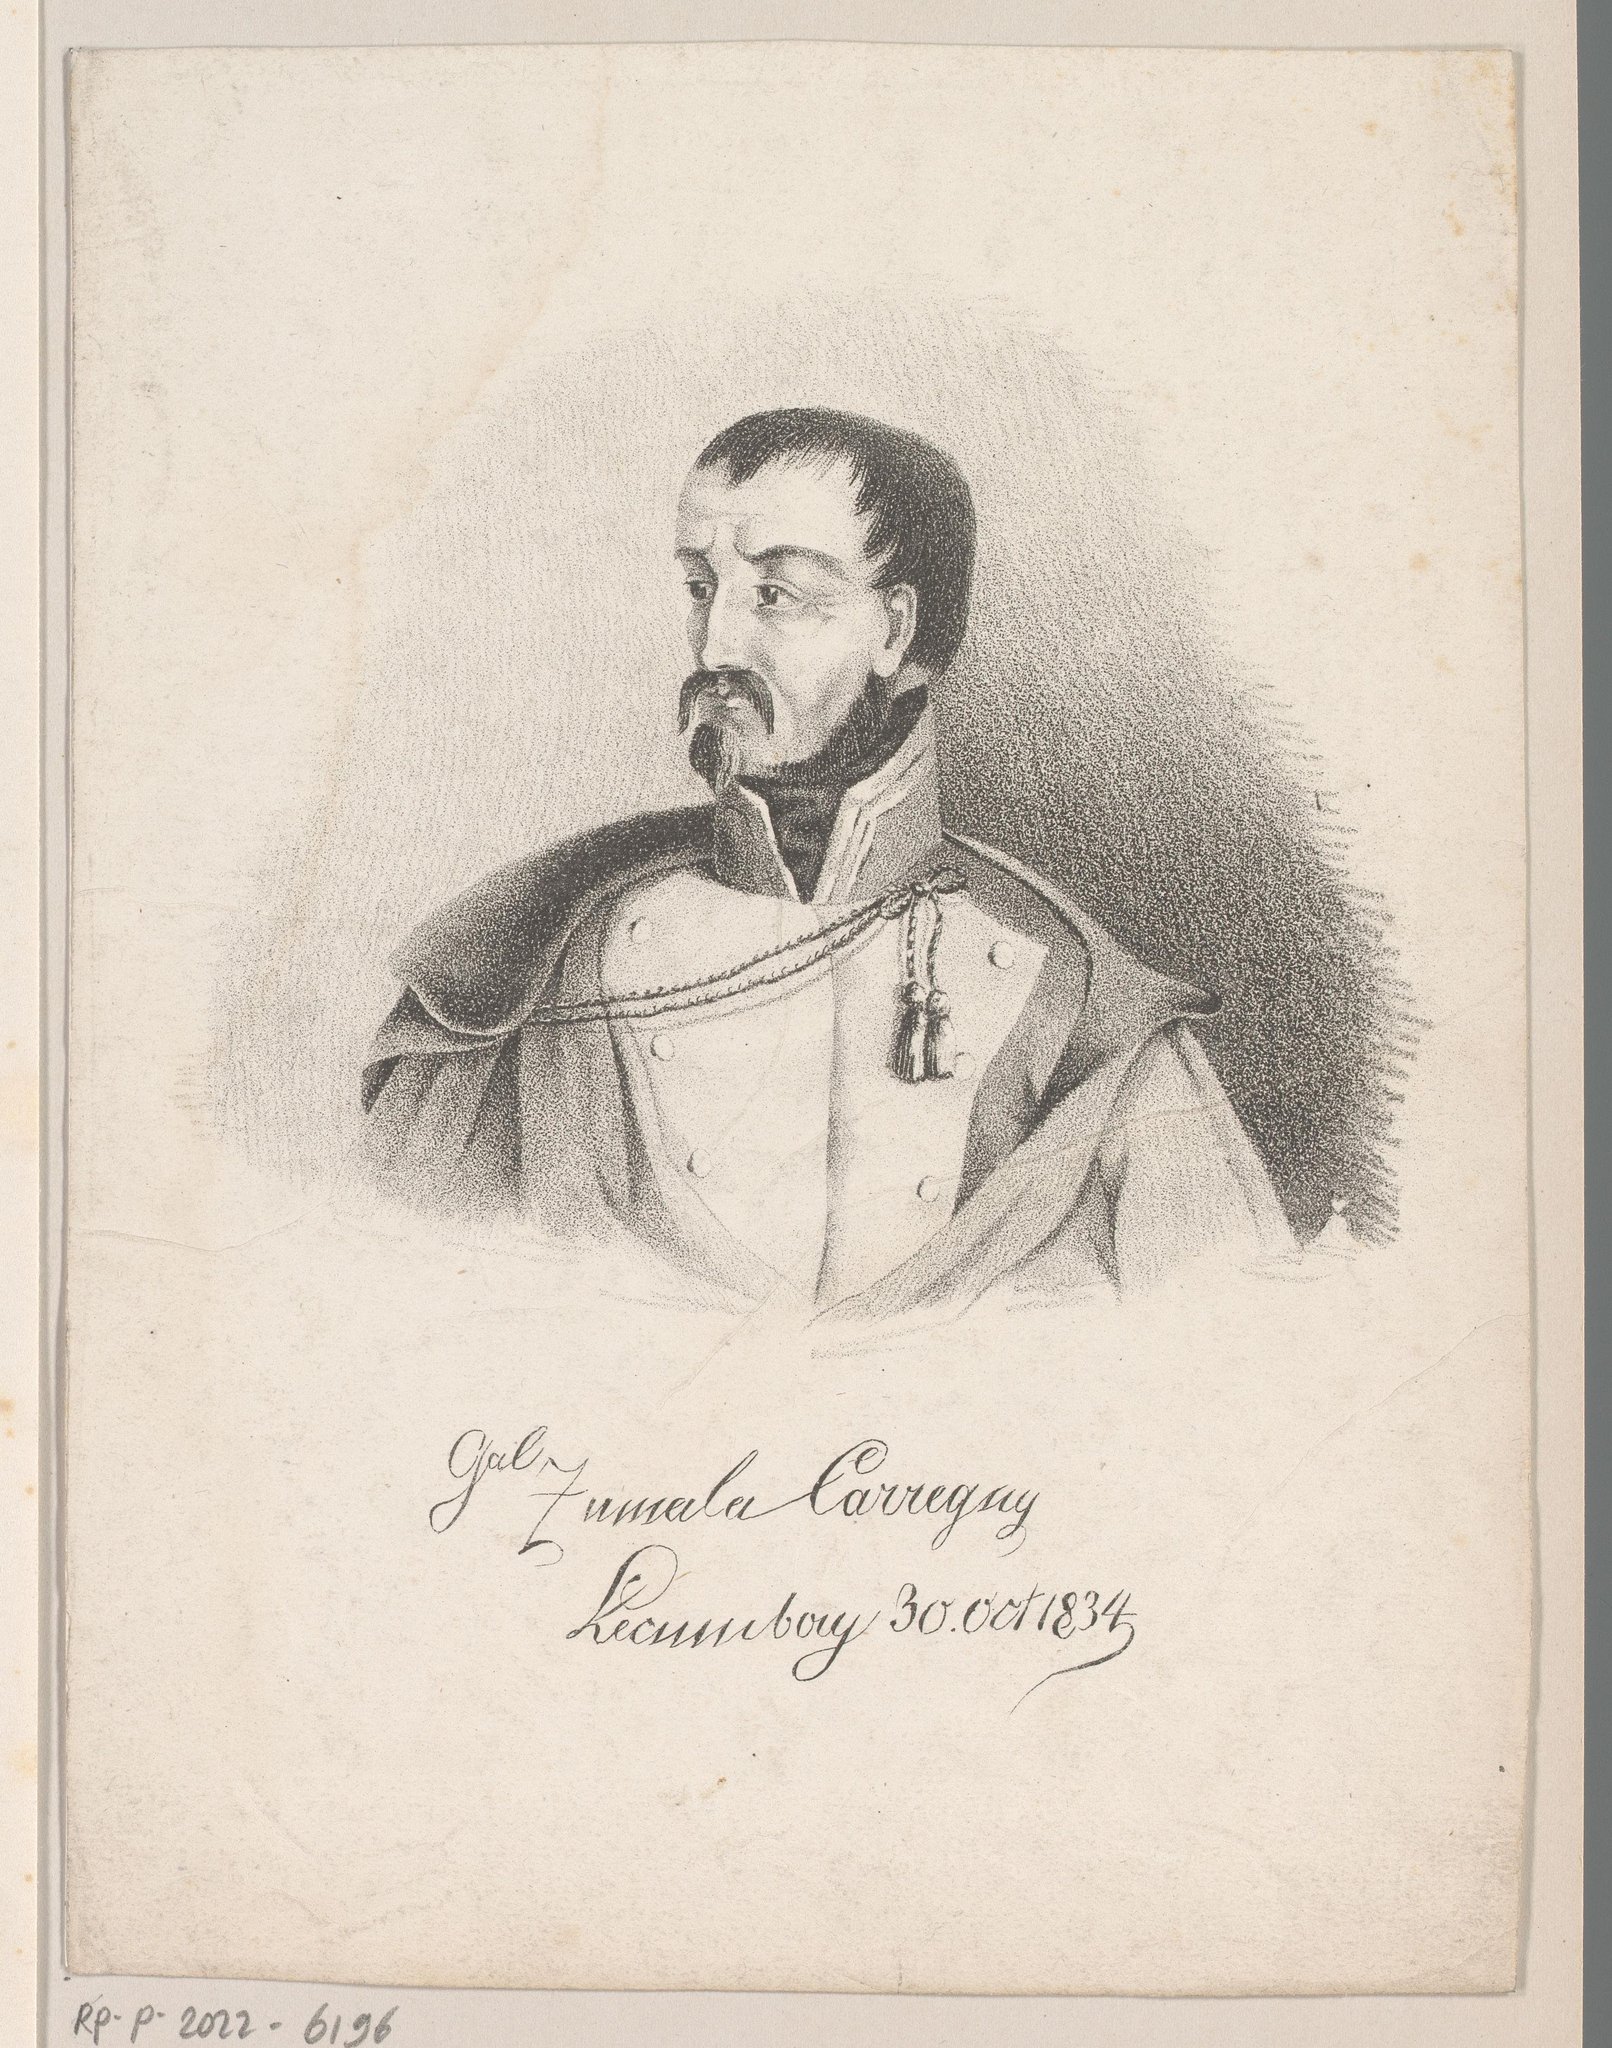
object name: print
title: Portret van Tomas Zumala-Carréguy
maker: Anonymous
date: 1808-1850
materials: paper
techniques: lithograph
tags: ranks in the army, historical persons